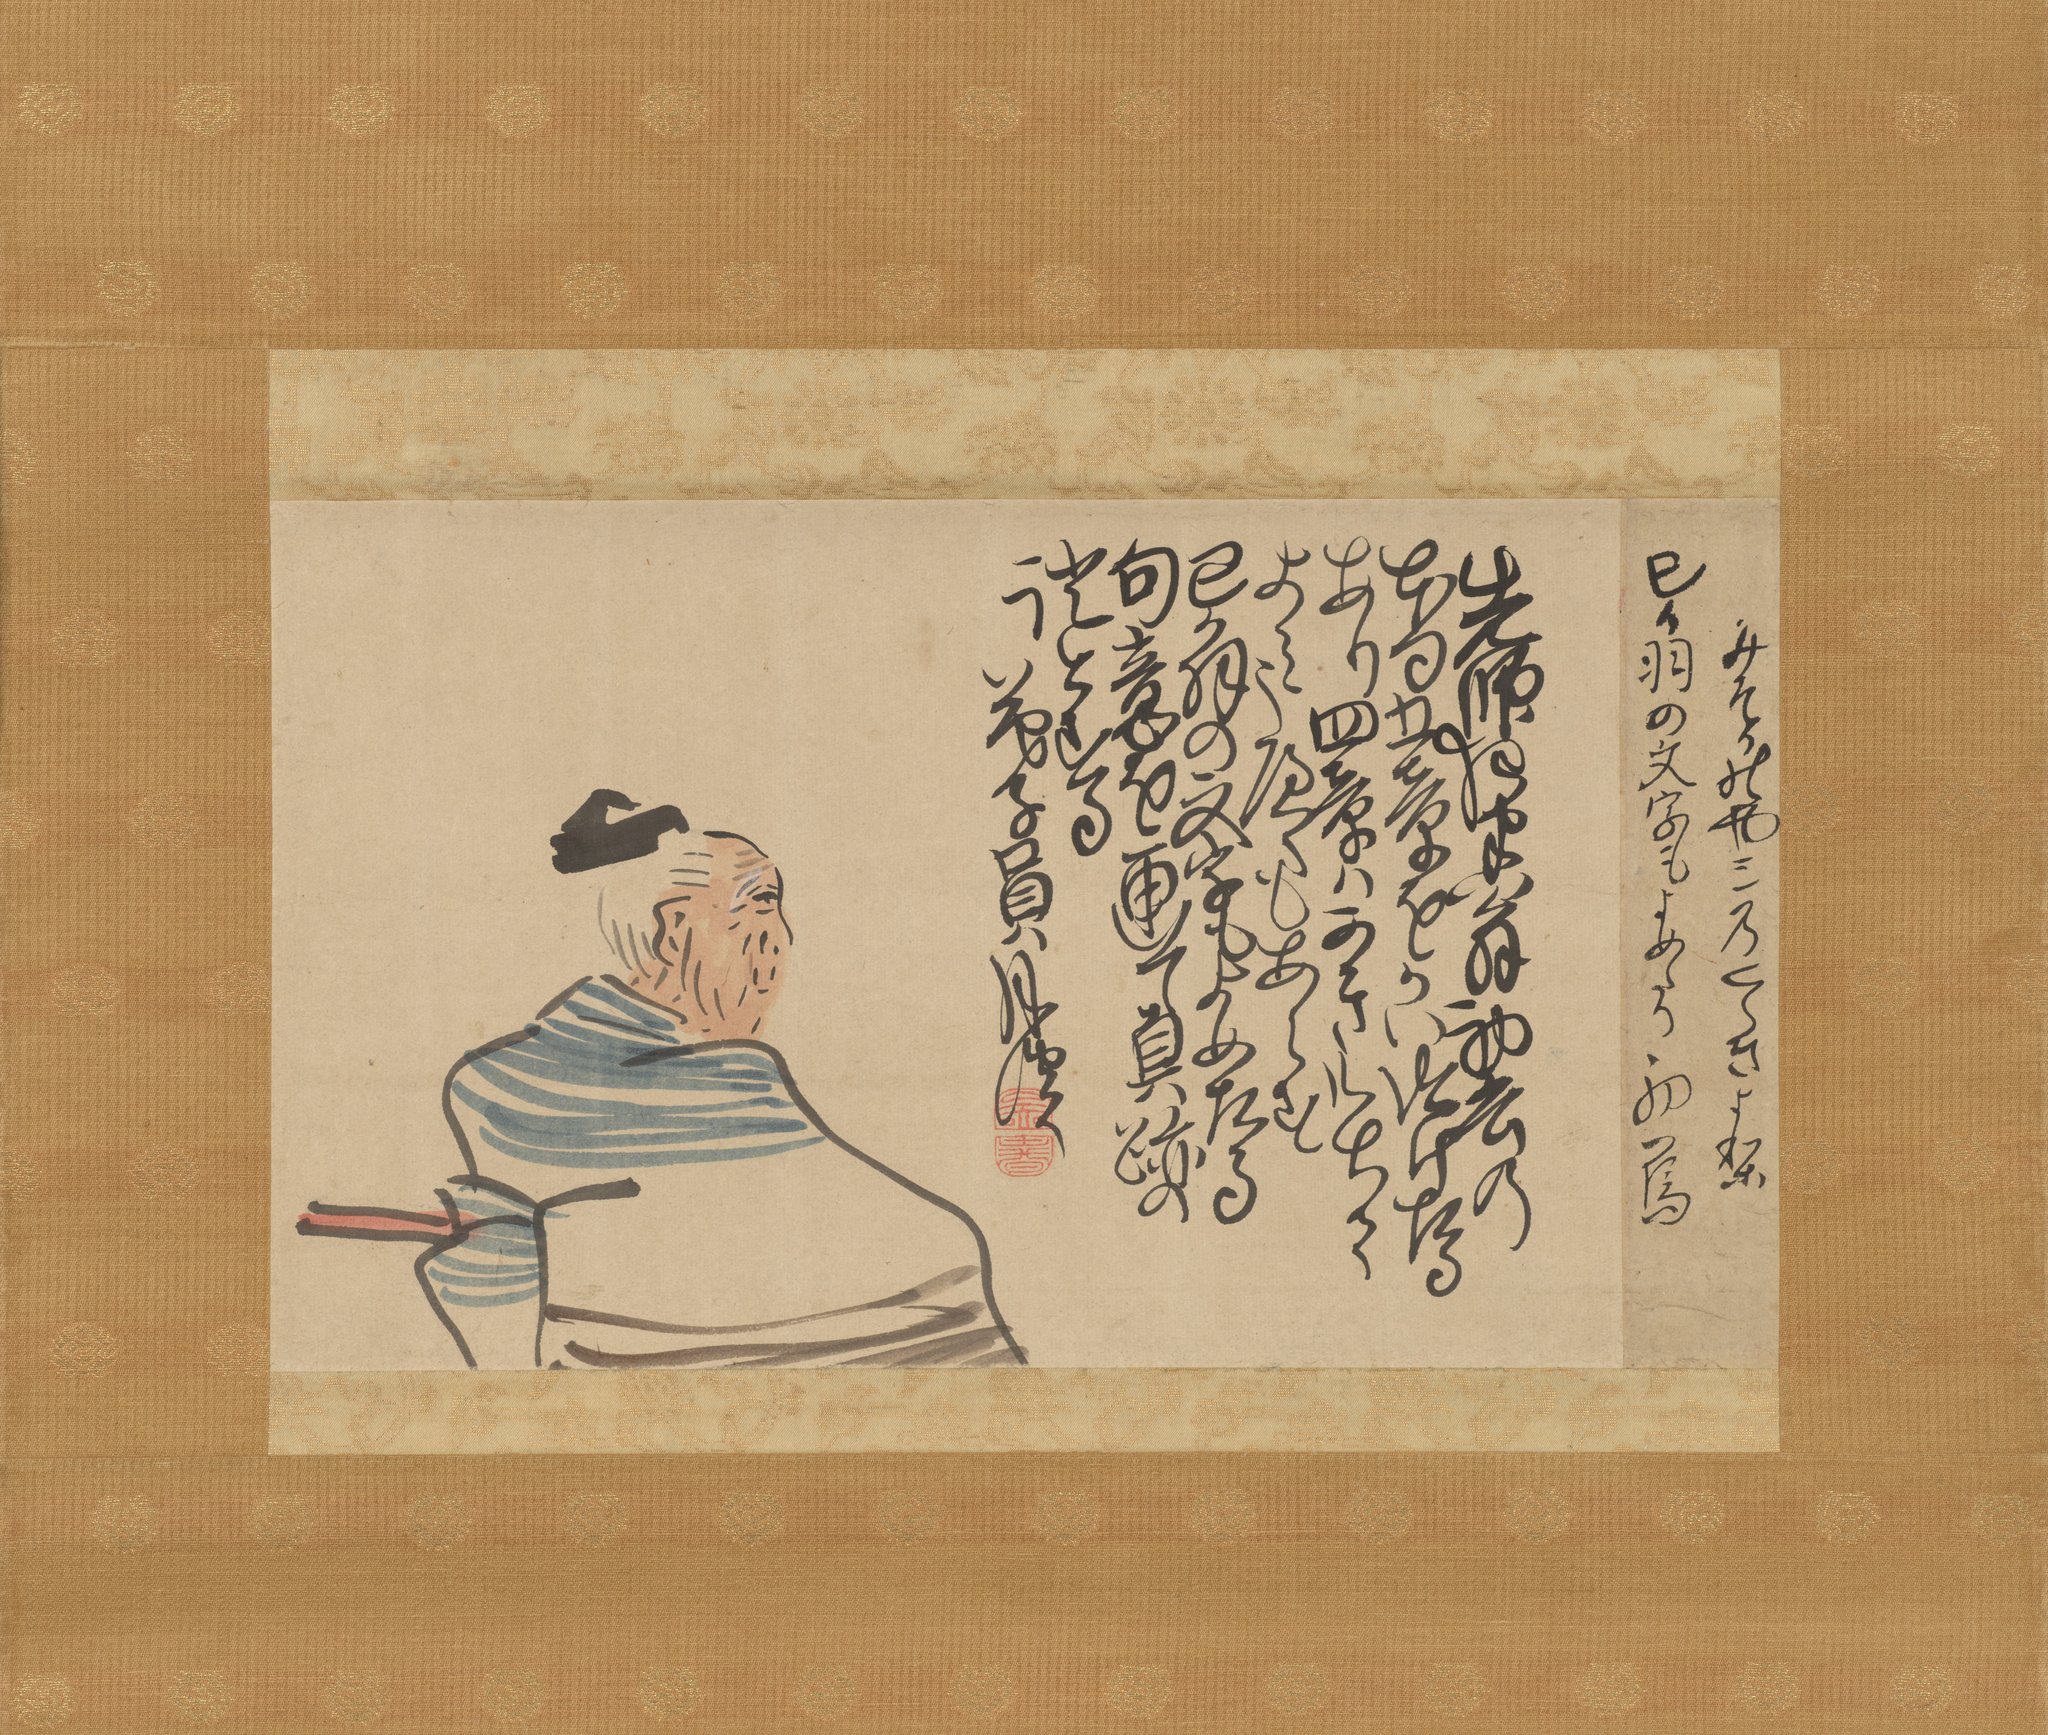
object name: hanging scroll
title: Hokku on “New Year’s Crow,” with a Painting of a Courtier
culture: japanese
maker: yosa buson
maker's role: artist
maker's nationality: japanese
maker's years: 1716-1783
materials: ink, paper